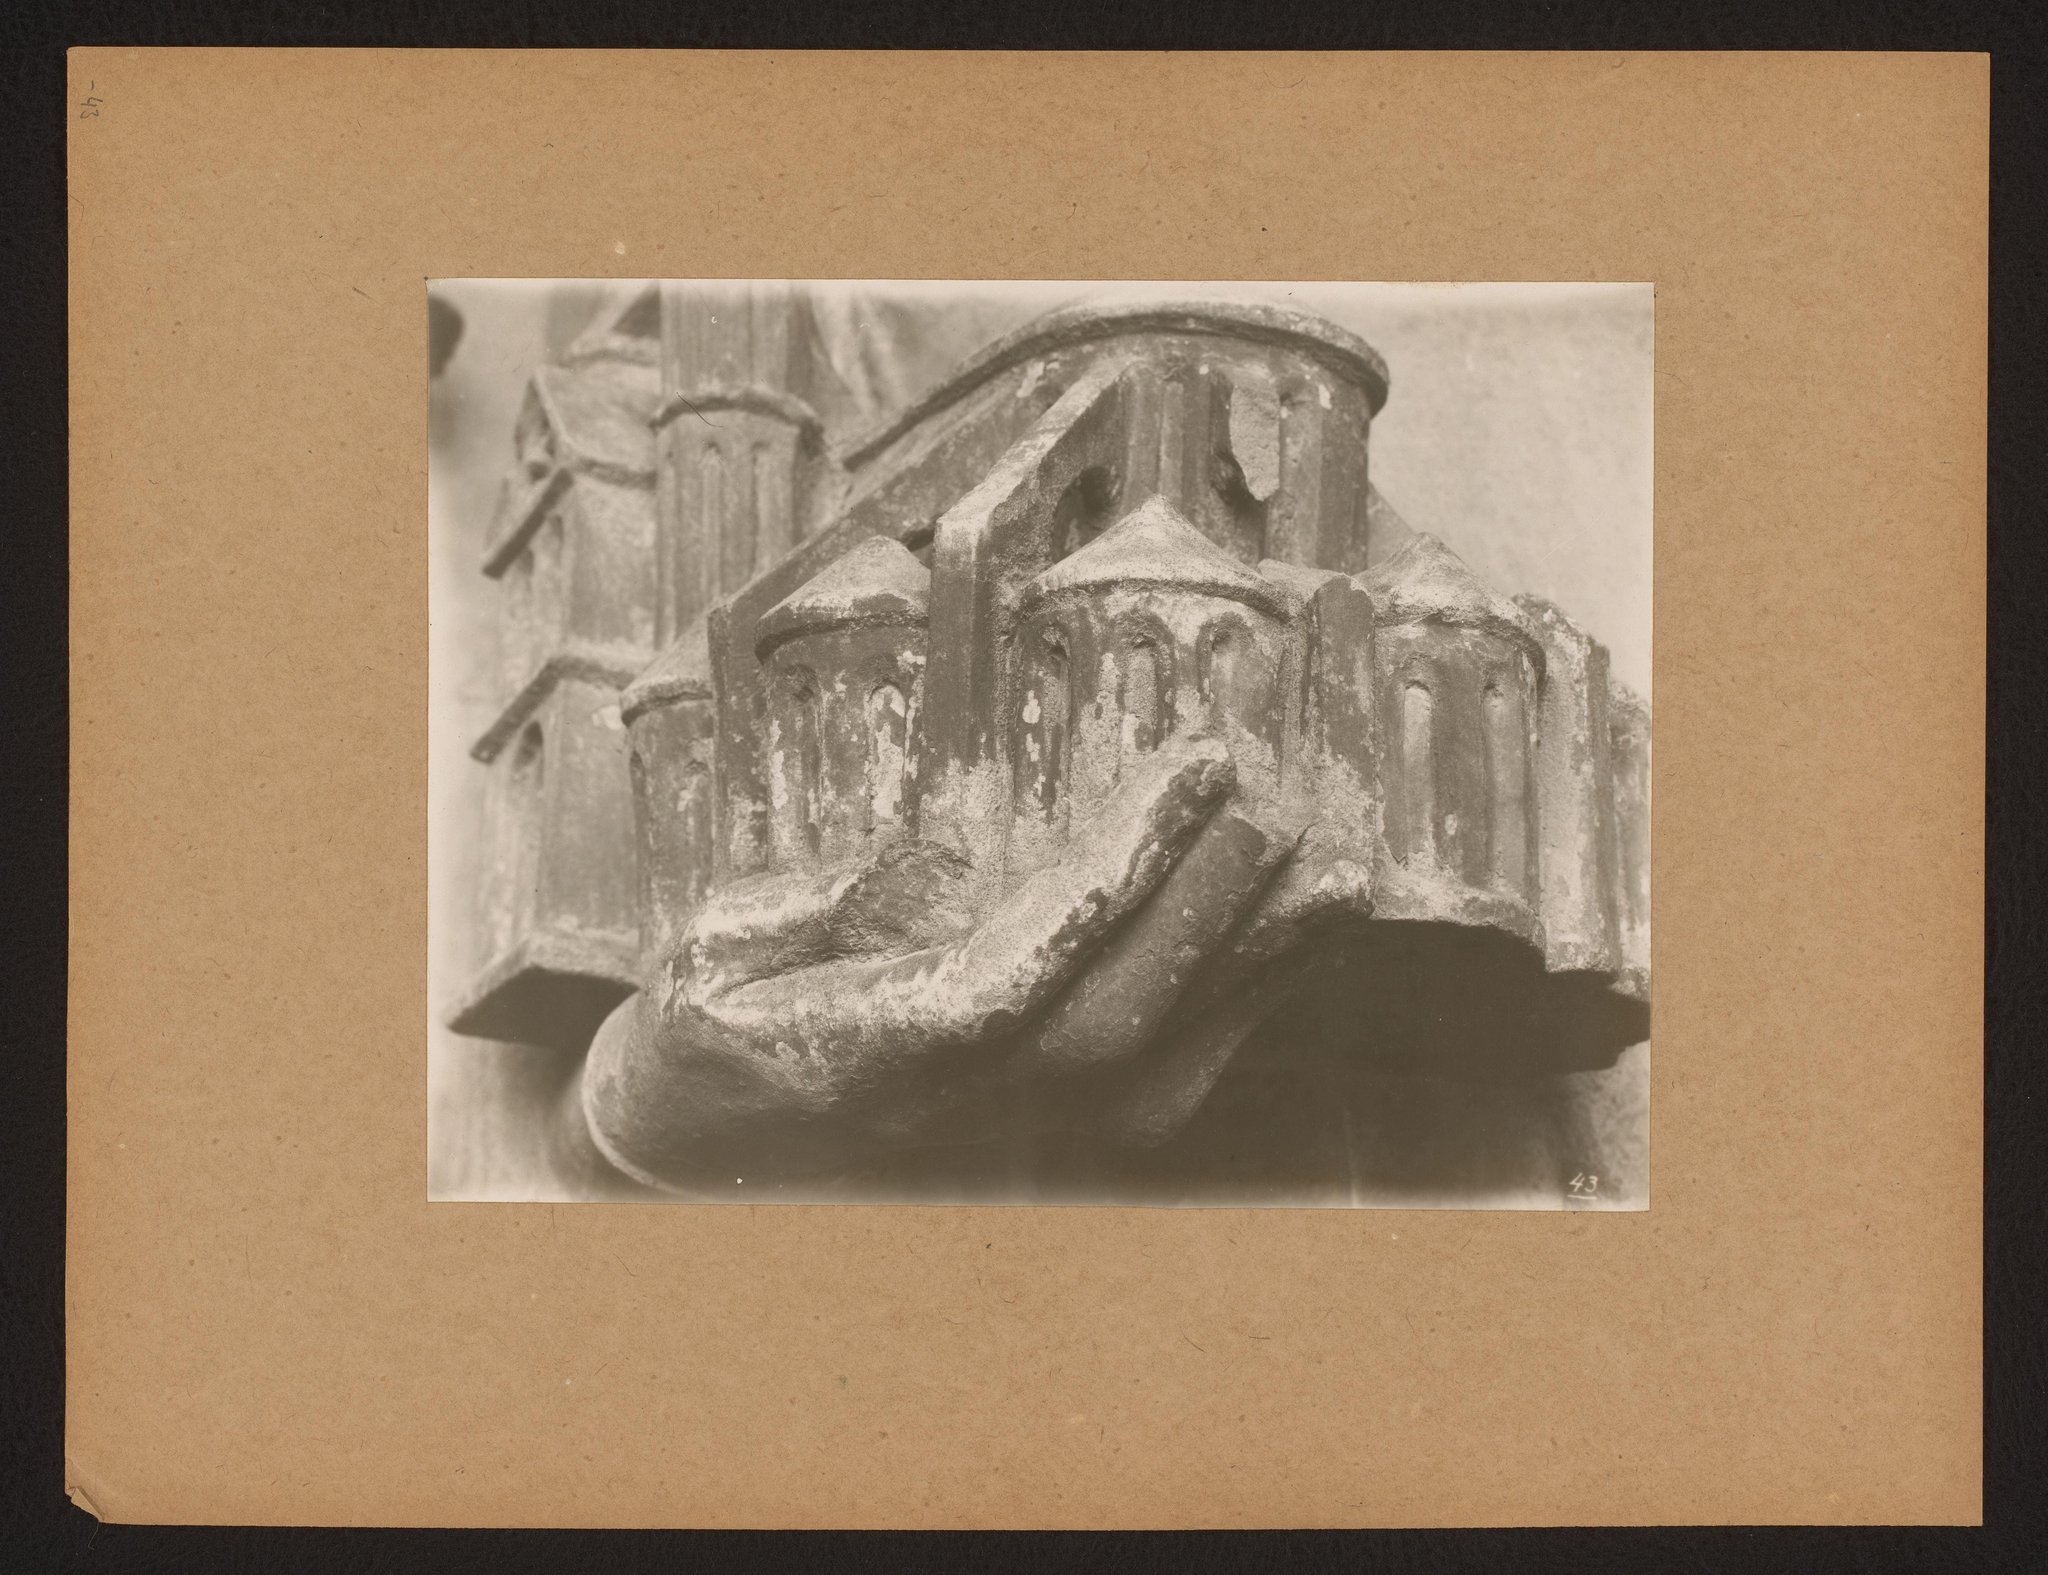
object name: photograph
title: Adamspforte (r.Hand u.Modell)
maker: Anonymous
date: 1900-1920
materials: paper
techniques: gelatin silver print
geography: bamberg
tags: church (exterior)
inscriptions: number: ‘43’